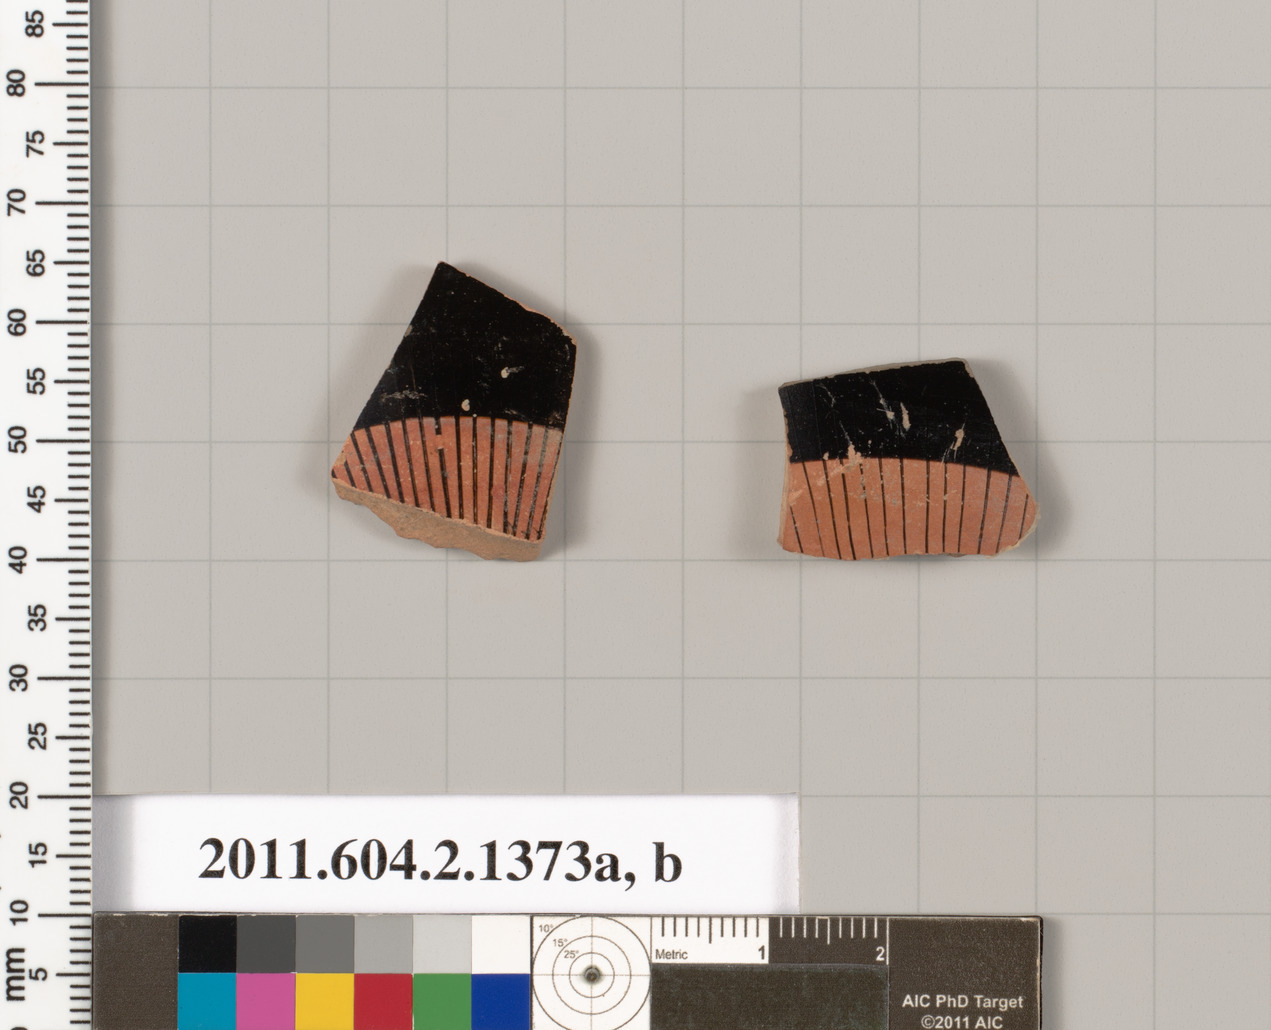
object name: skyphos fragment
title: Terracotta fragments of skyphoi (deep drinking cups)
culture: greek, attic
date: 475-451 BCE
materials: terracotta